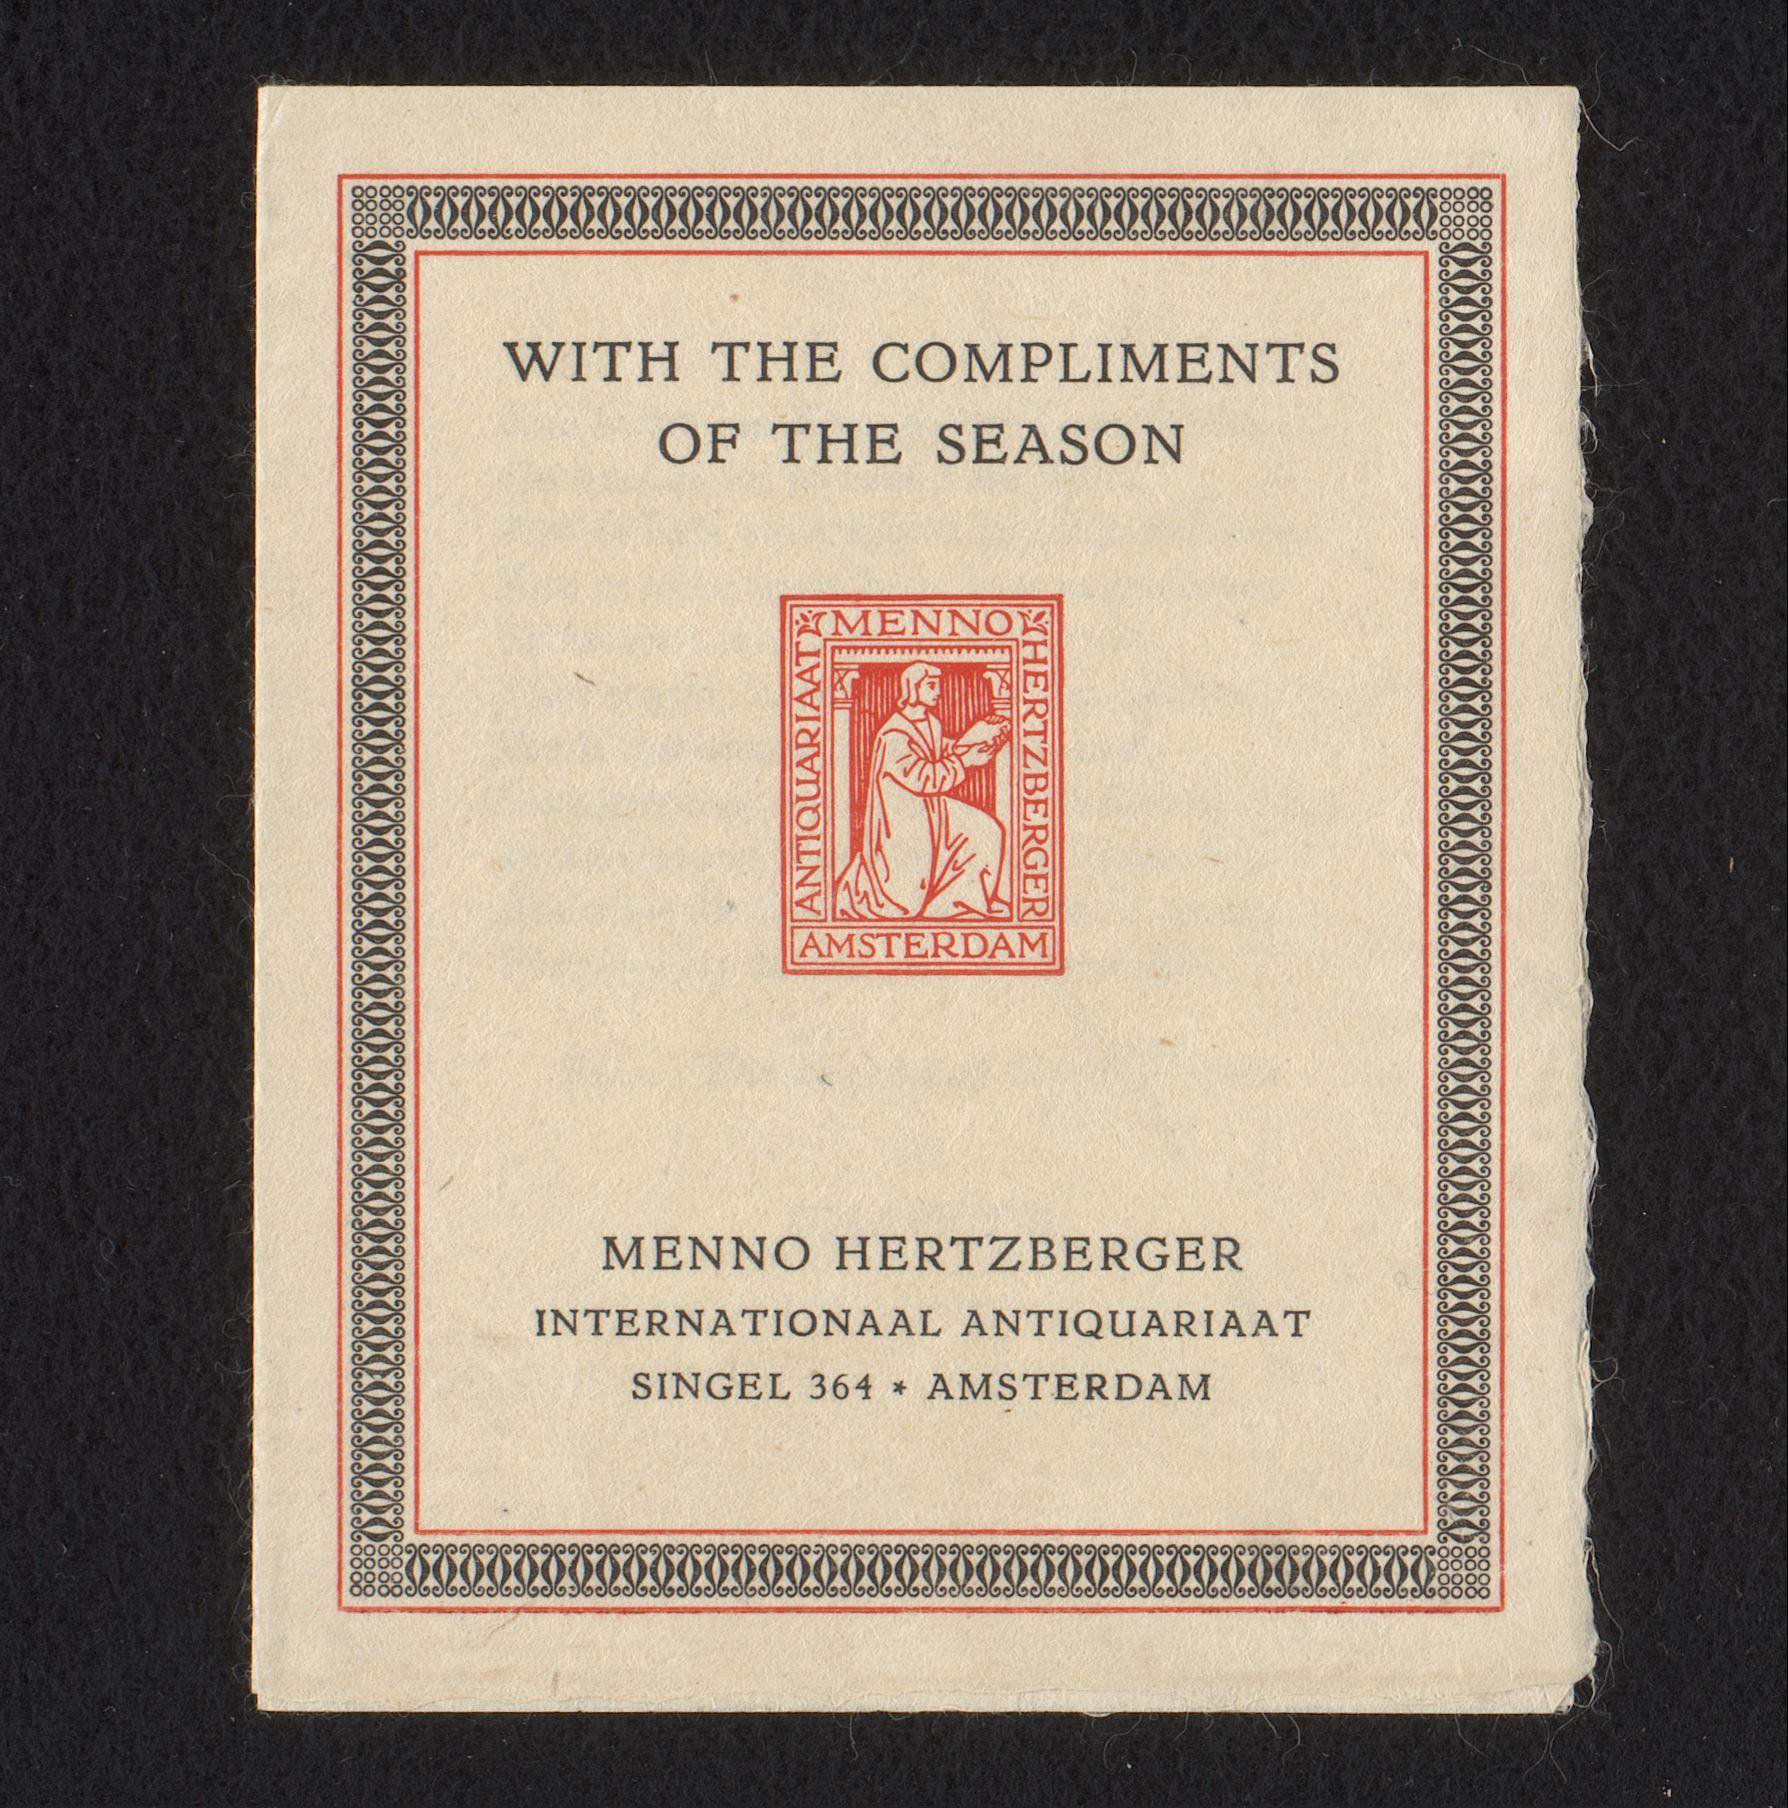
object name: greeting card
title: Wenskaart van antiquariaat Menno Hertzberger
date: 1923-1982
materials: paper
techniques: letterpress printing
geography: amsterdam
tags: reading, device (trade-mark of printer or publisher)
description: Gevouwen blad met op de voorzijde in een decoratief kader 'With the Compliments of the Season' en het merk van Menno Hertzberger, evenals het adres van het antiquariaat. Binnenin een fragment uit 'The Legend of Good Women' door Geoffrey Chaucer.